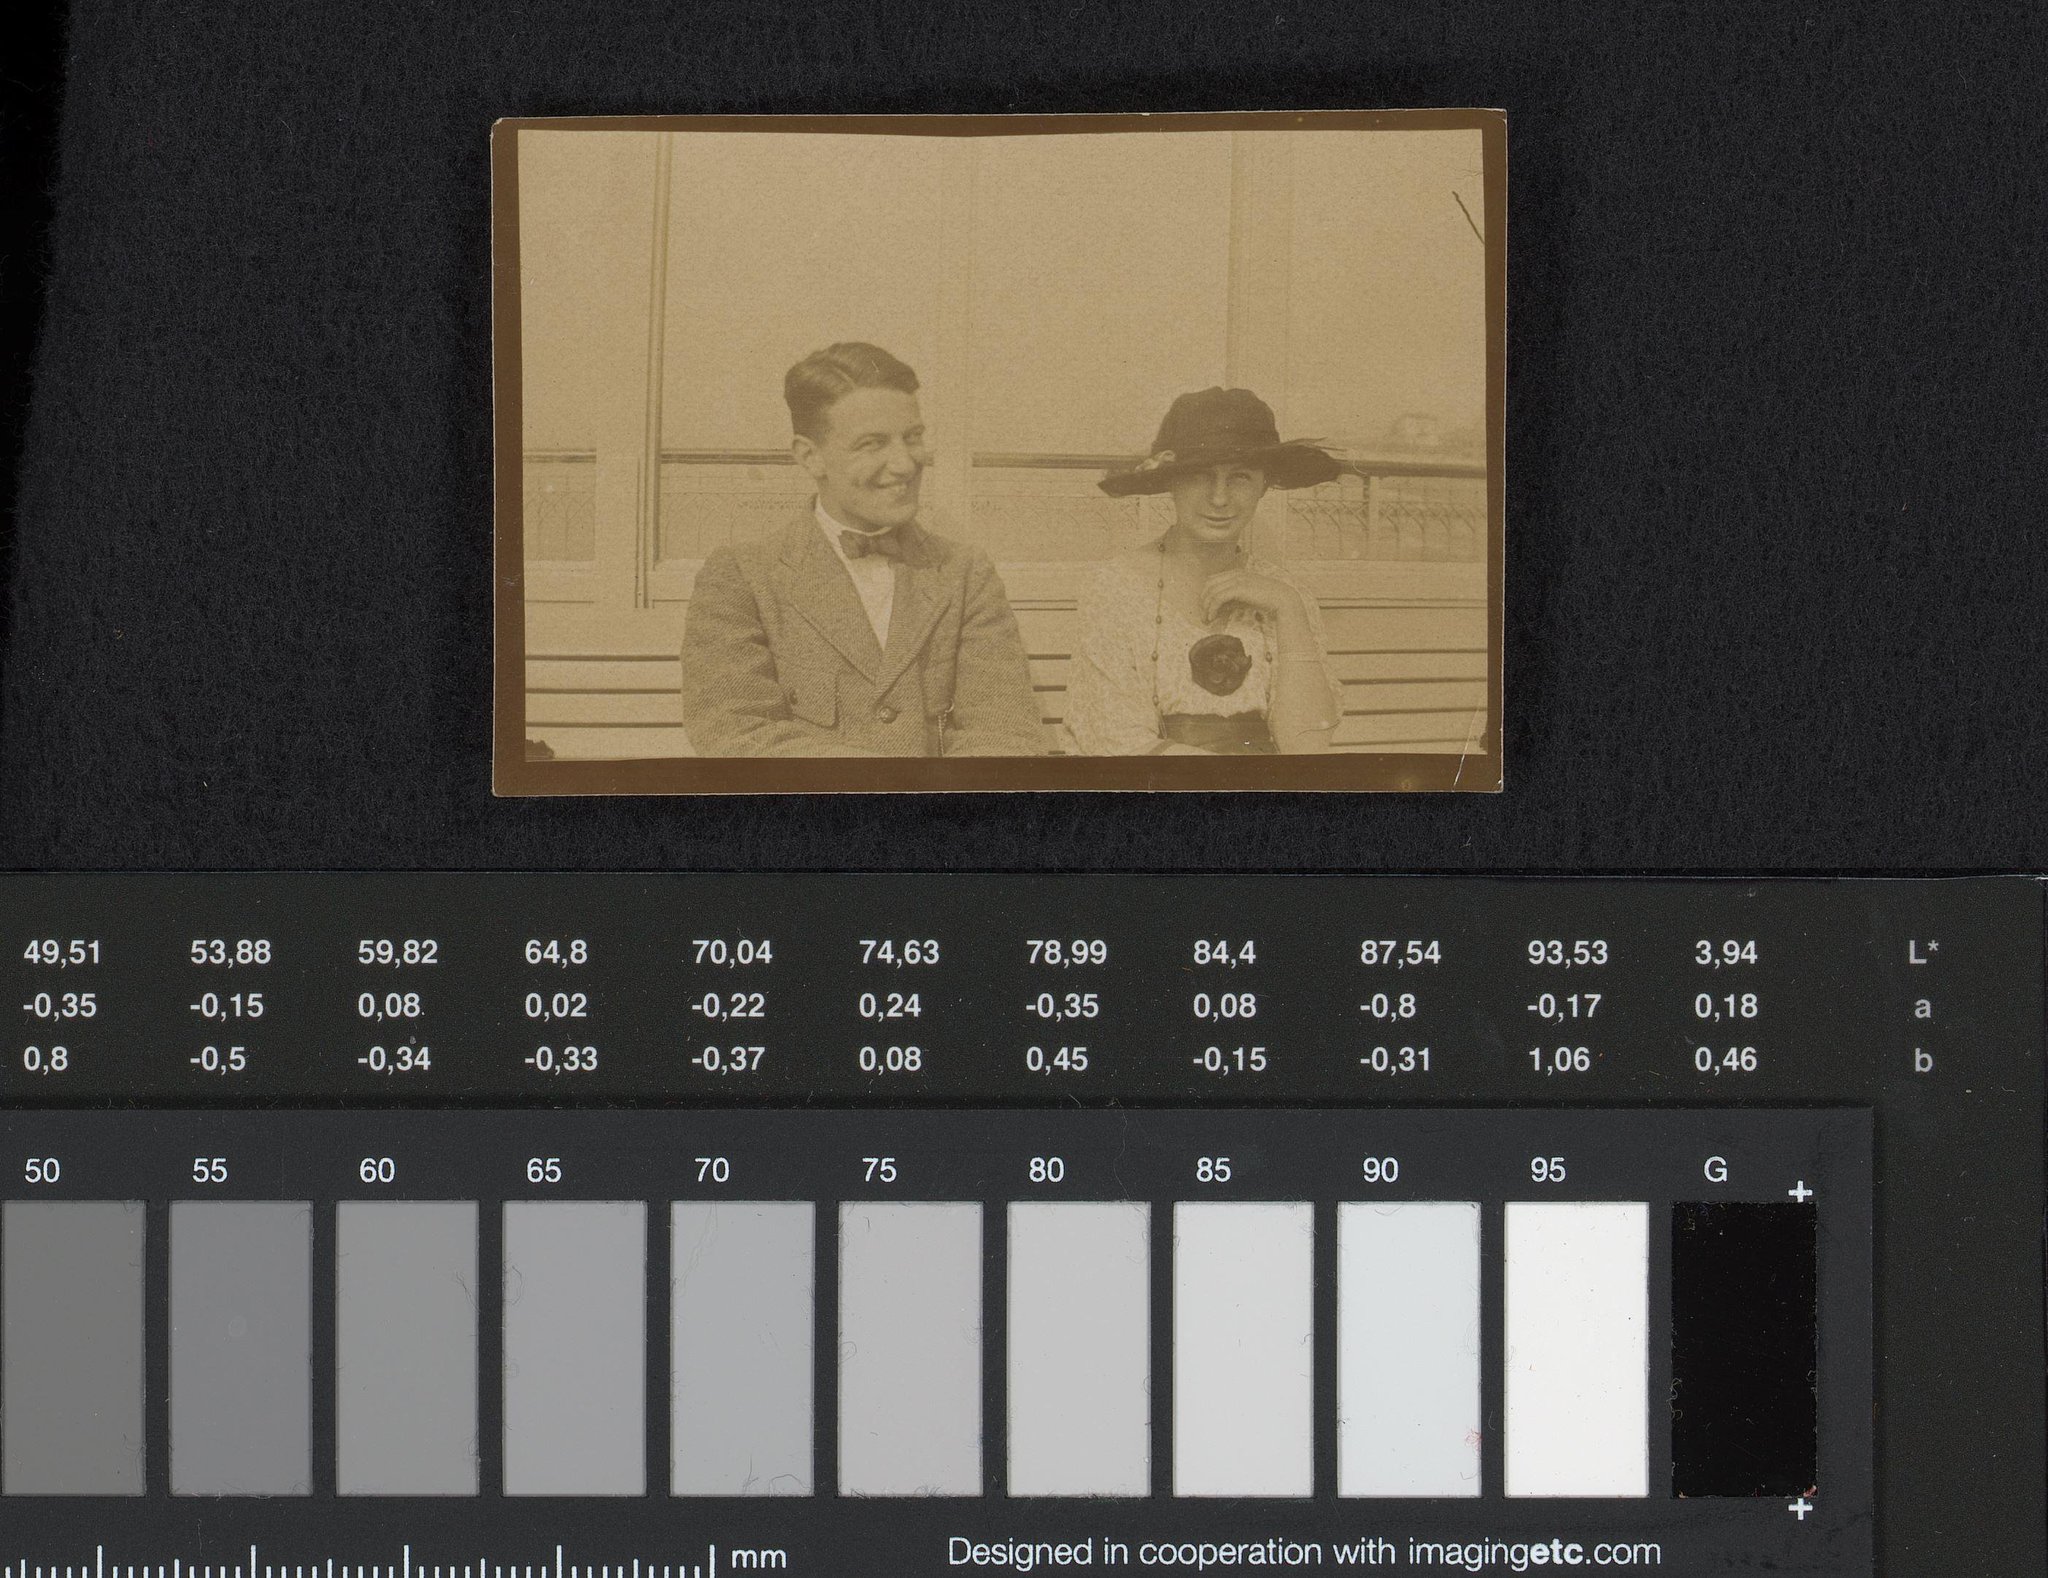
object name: photograph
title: Portret van onbekende man en vrouw aan zee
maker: Anonymous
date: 1920-1925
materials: paper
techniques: gelatin silver print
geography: south holland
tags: adult woman, adult man